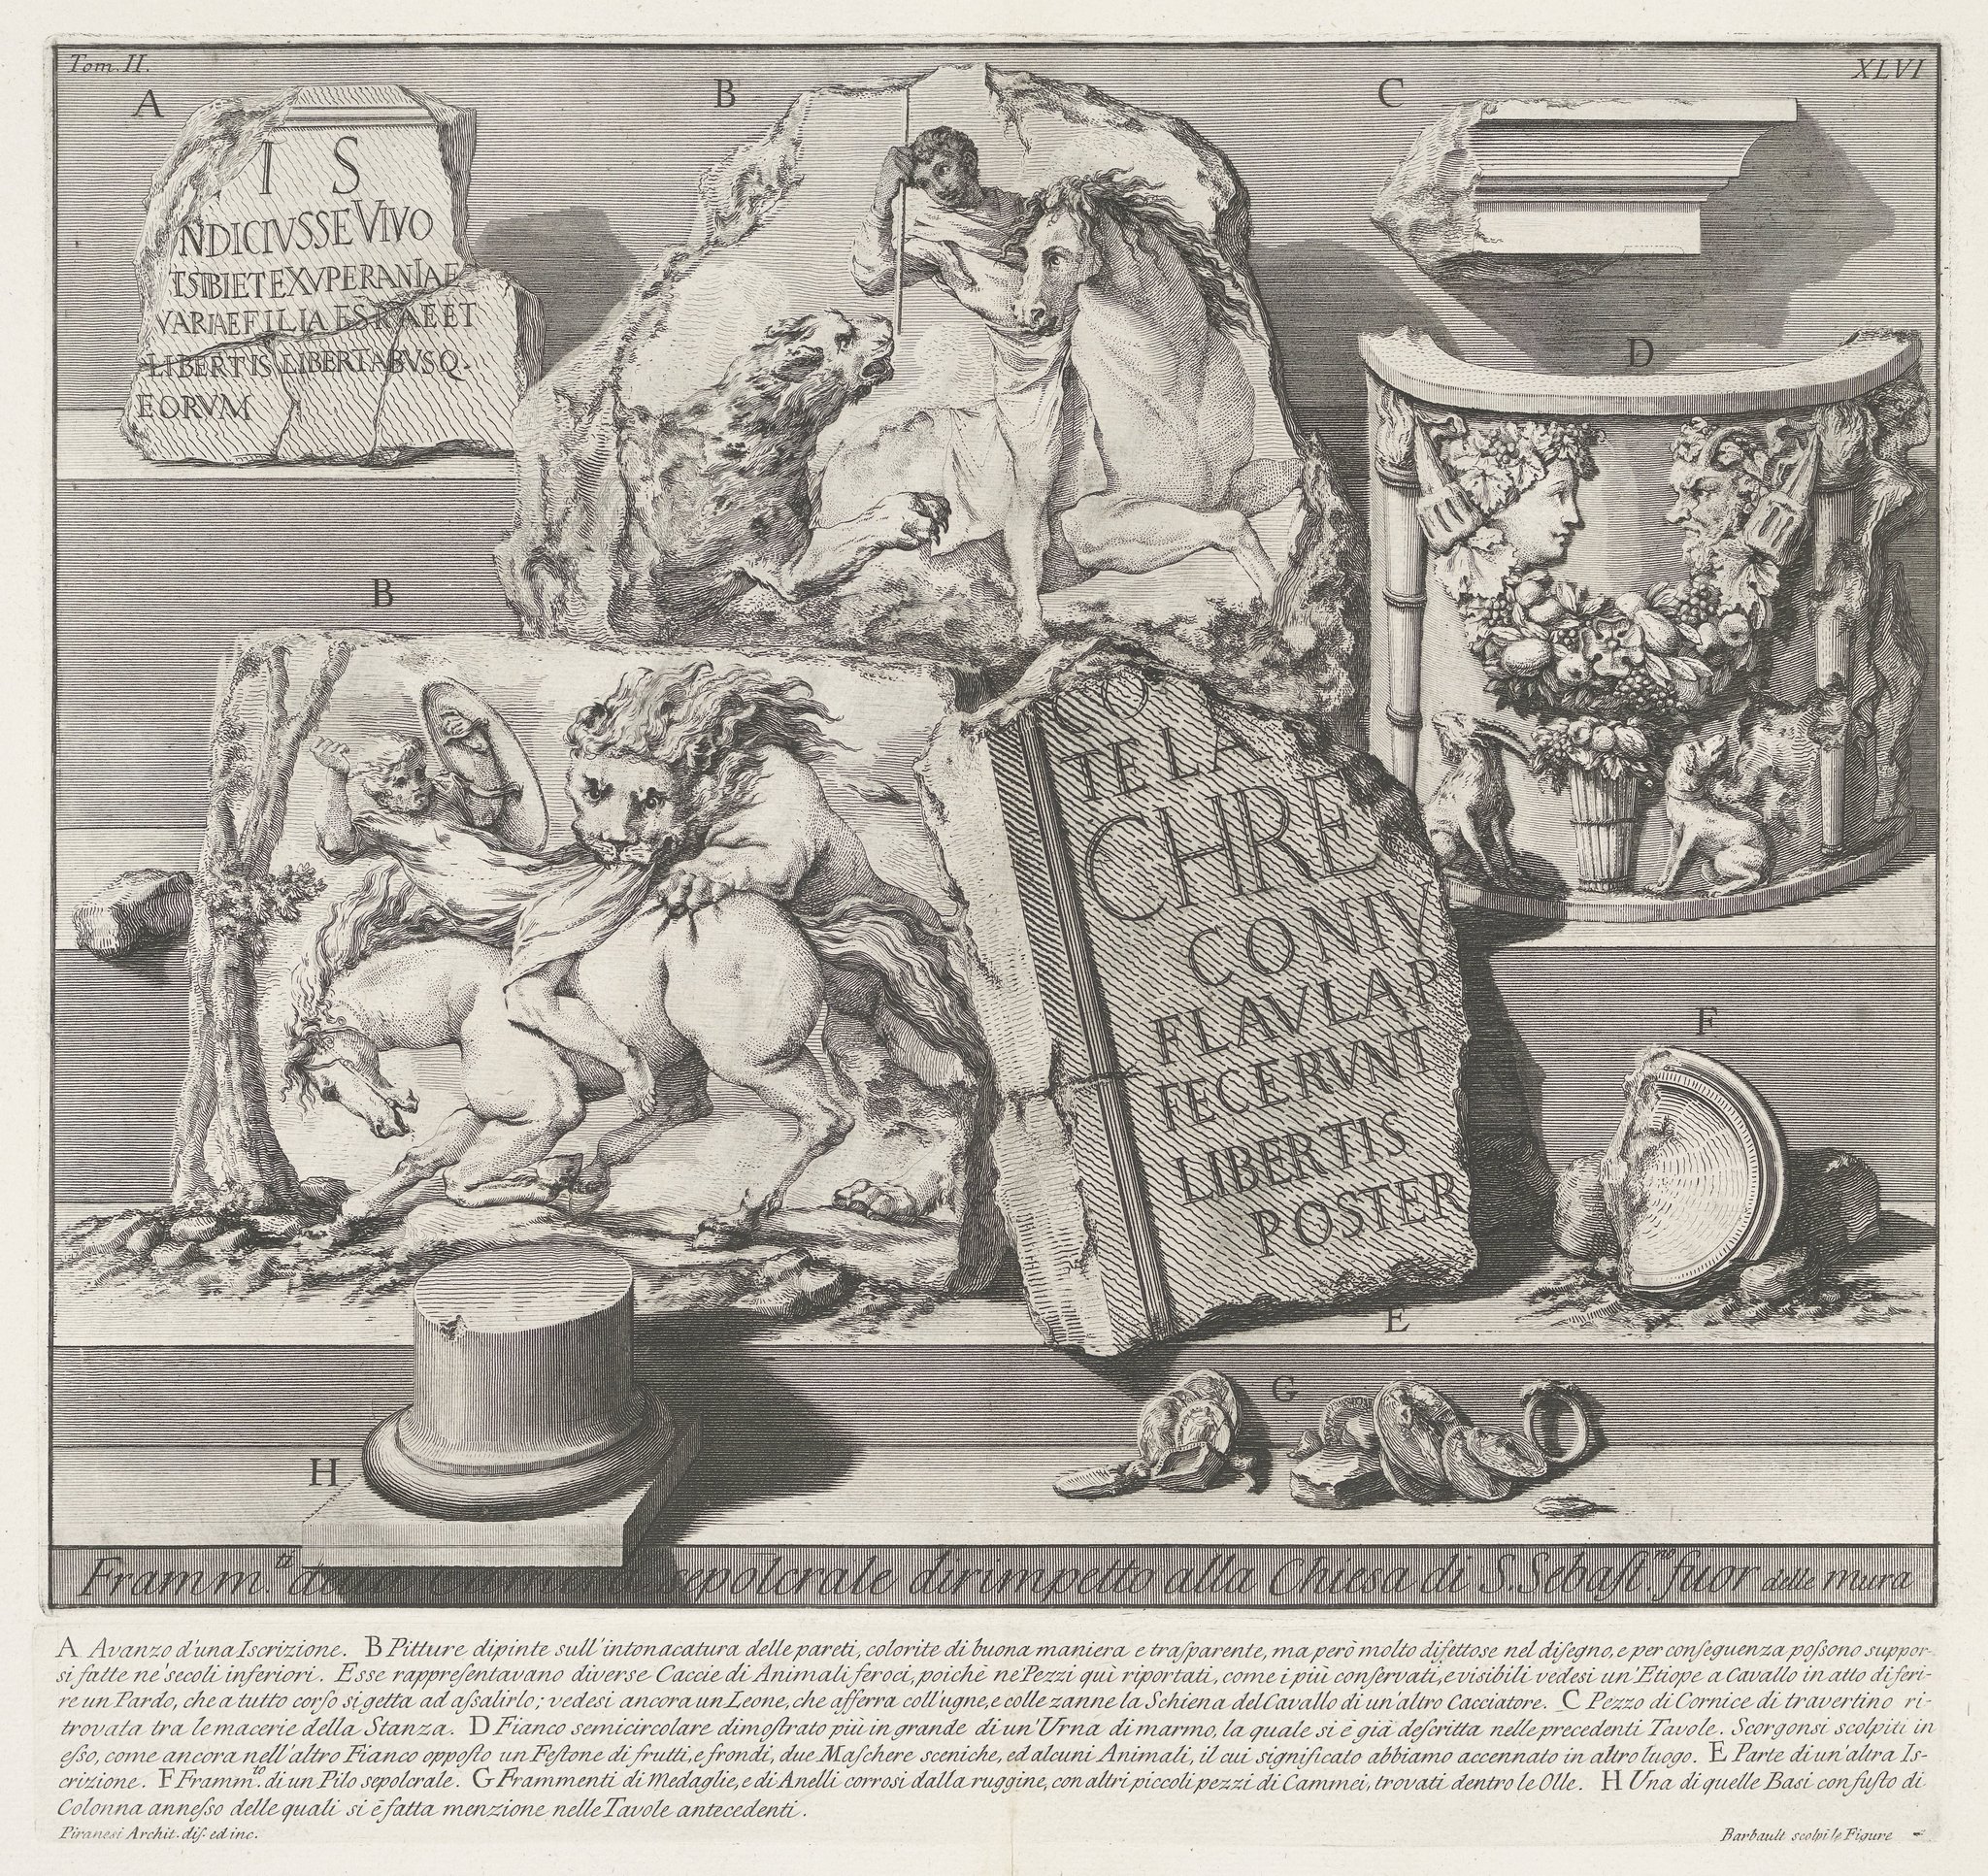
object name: print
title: Archeologische vondsten in en rond Rome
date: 1756-1757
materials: paper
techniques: etching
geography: rome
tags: inscription, piece of sculpture, reproduction of a piece of sculpture, base (~ column, pillar)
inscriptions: collector's mark: Lugt 2228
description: Deze prent maakt deel uit van de serie 'Le Antichità Romane'. Piranesi deed meer dan acht jaar voorstudie voor deze 250 platen tellende serie die in vier volumes werd uitgegeven. Hij produceerde de prenten tussen ca. 1756 en 1757. De serie bevat ook prenten door of naar andere prentmakers, onder wie Francesco Bianchini en Girolamo Rossi.